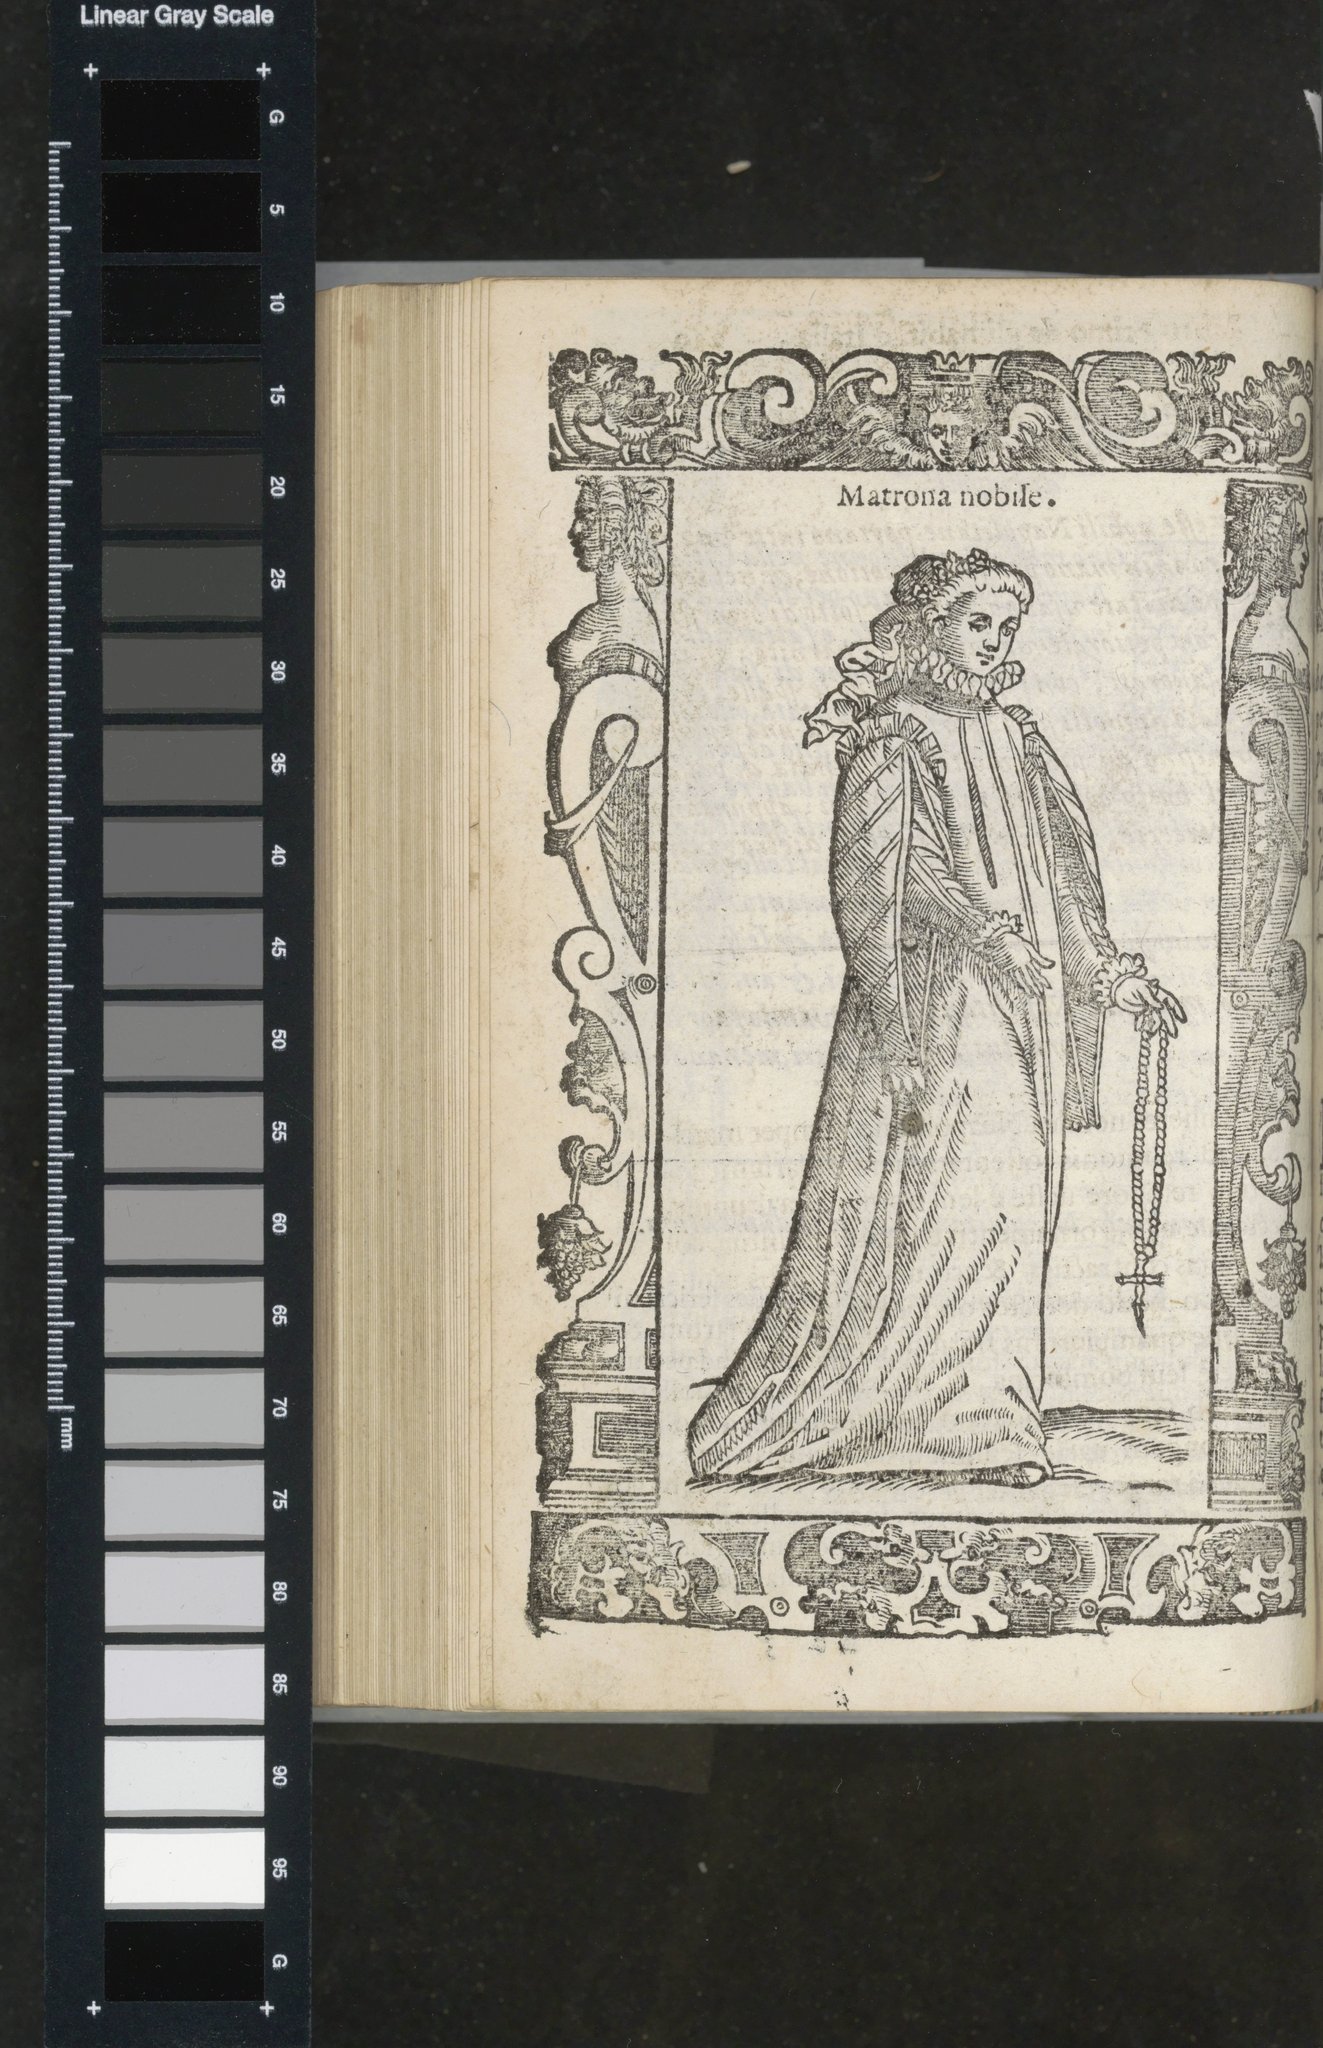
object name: costume print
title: Getrouwde adellijke dame uit Napels in zomerkleding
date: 1598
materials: paper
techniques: woodcut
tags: aids for prayer, e.g. rosary, fashion plates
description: Napolitaanse dame met rozenkrans in de hand (volgens Vecellio gebruikelijk bij Napolitaanse vrouwen)